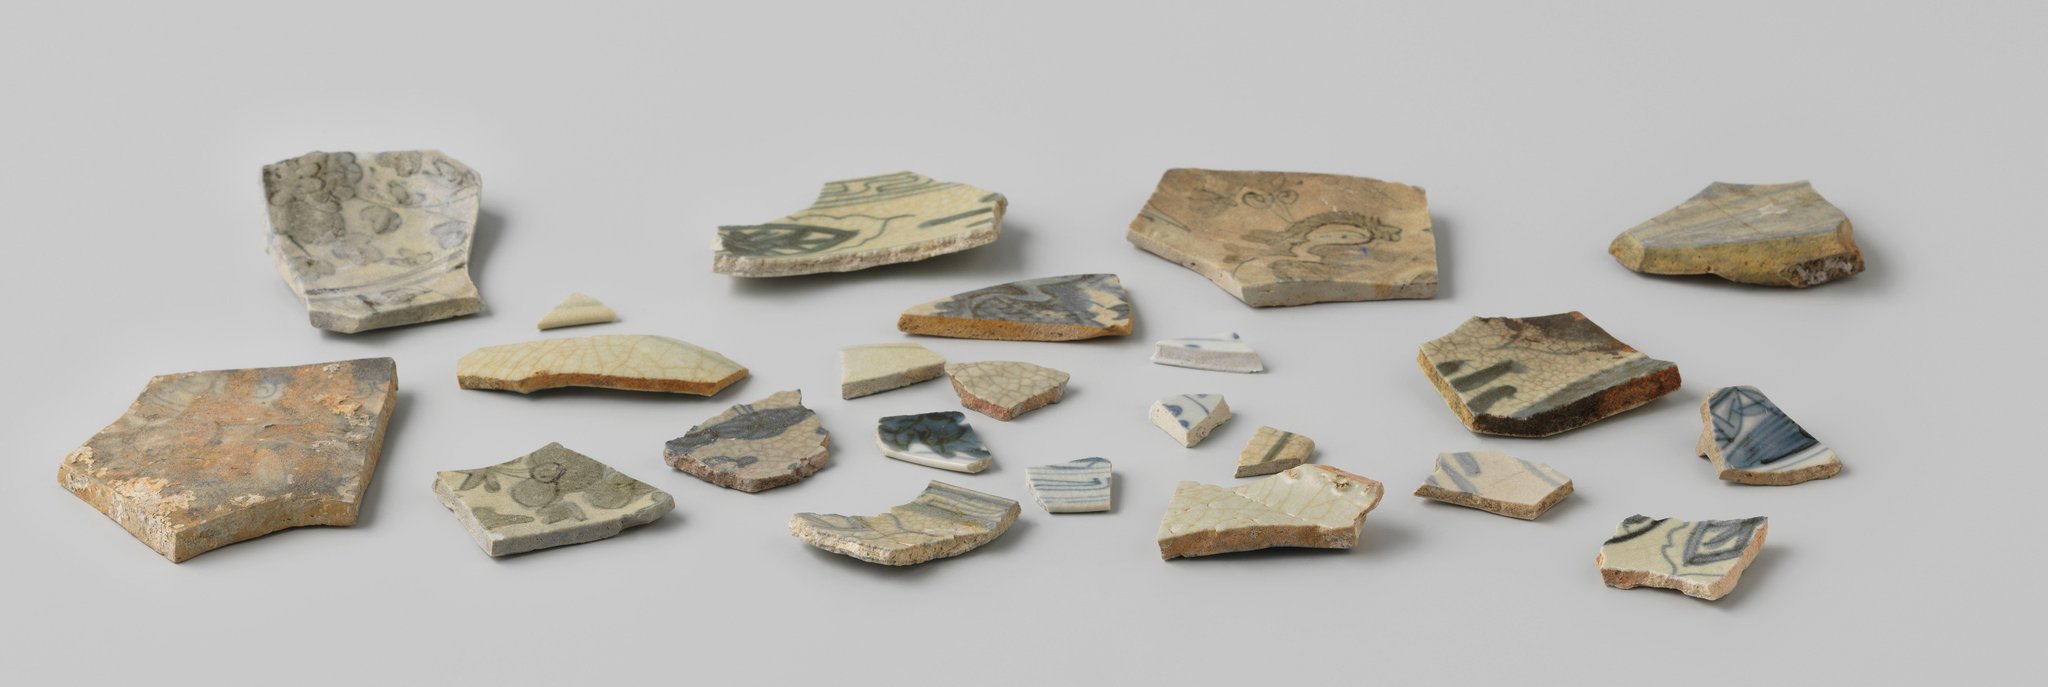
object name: plate dish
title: Scherven van borden uit V.O.C.-schip de 'Witte Leeuw'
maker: Anonymous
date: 1613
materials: porcelain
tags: verenigde oostindische compagnie, sint-helena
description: Scherven van borden uit V.O.C.-schip de 'Witte Leeuw'.